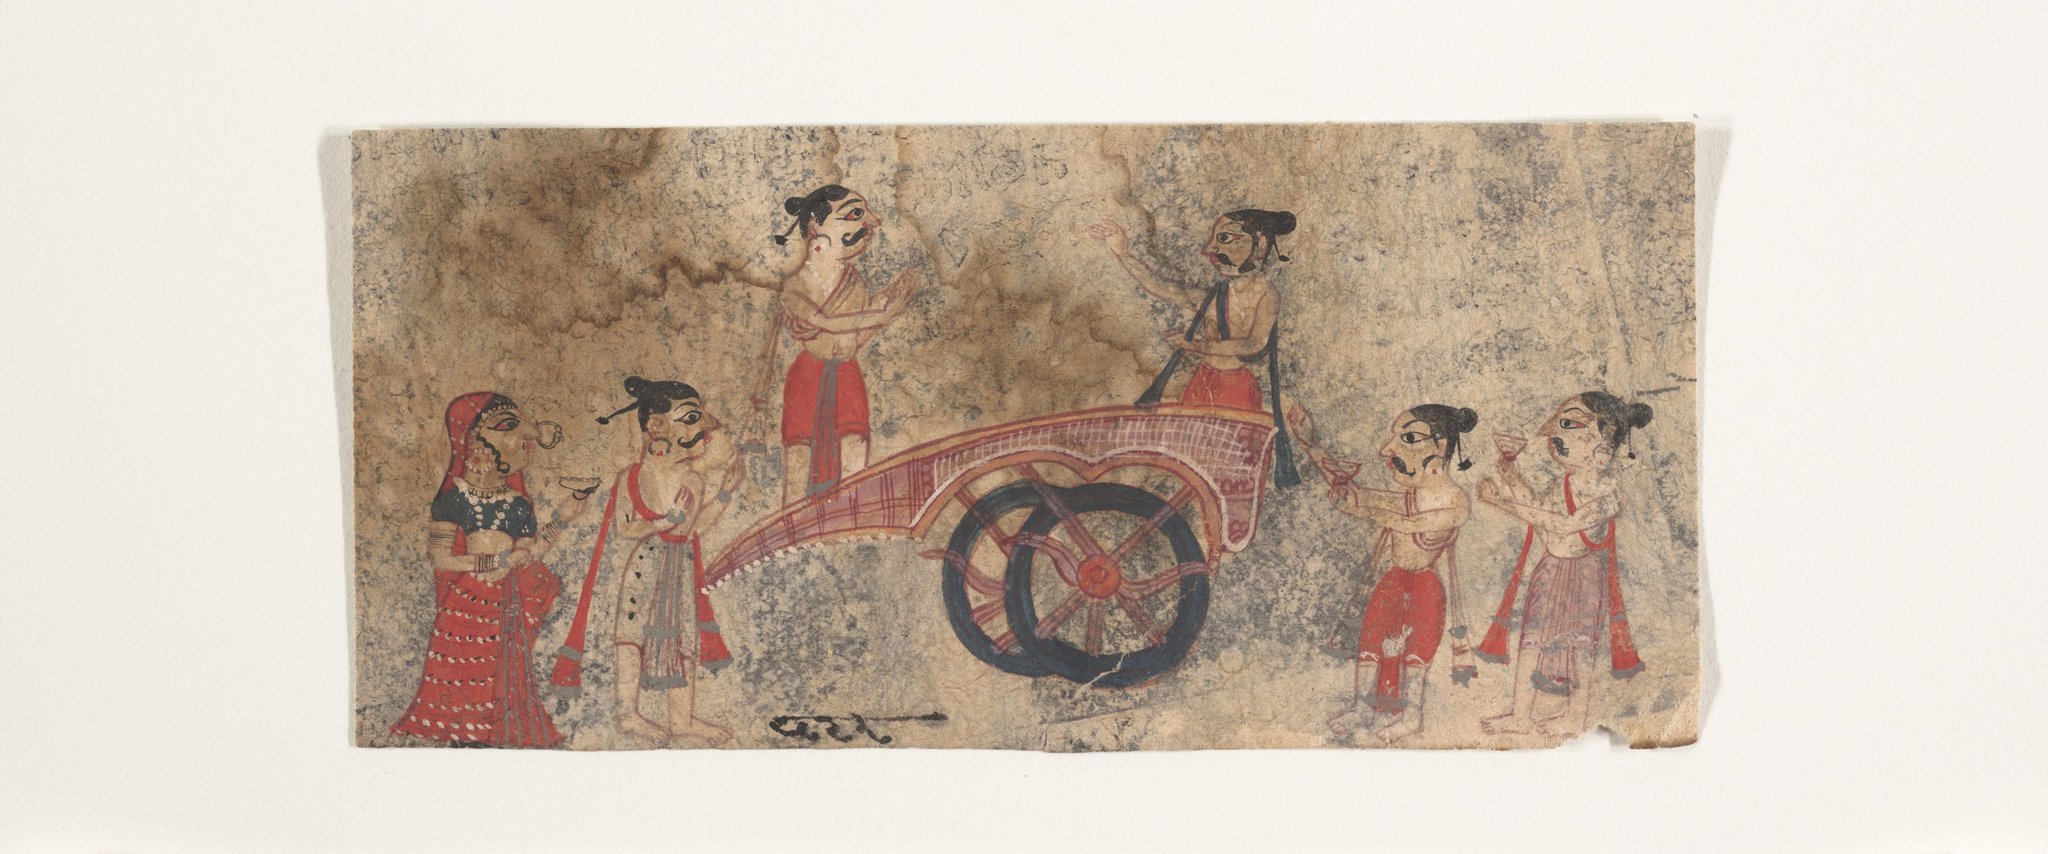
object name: painting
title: Disputations on a Chariot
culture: indian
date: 1650-1660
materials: ink, paper, watercolor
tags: men,women,chariots